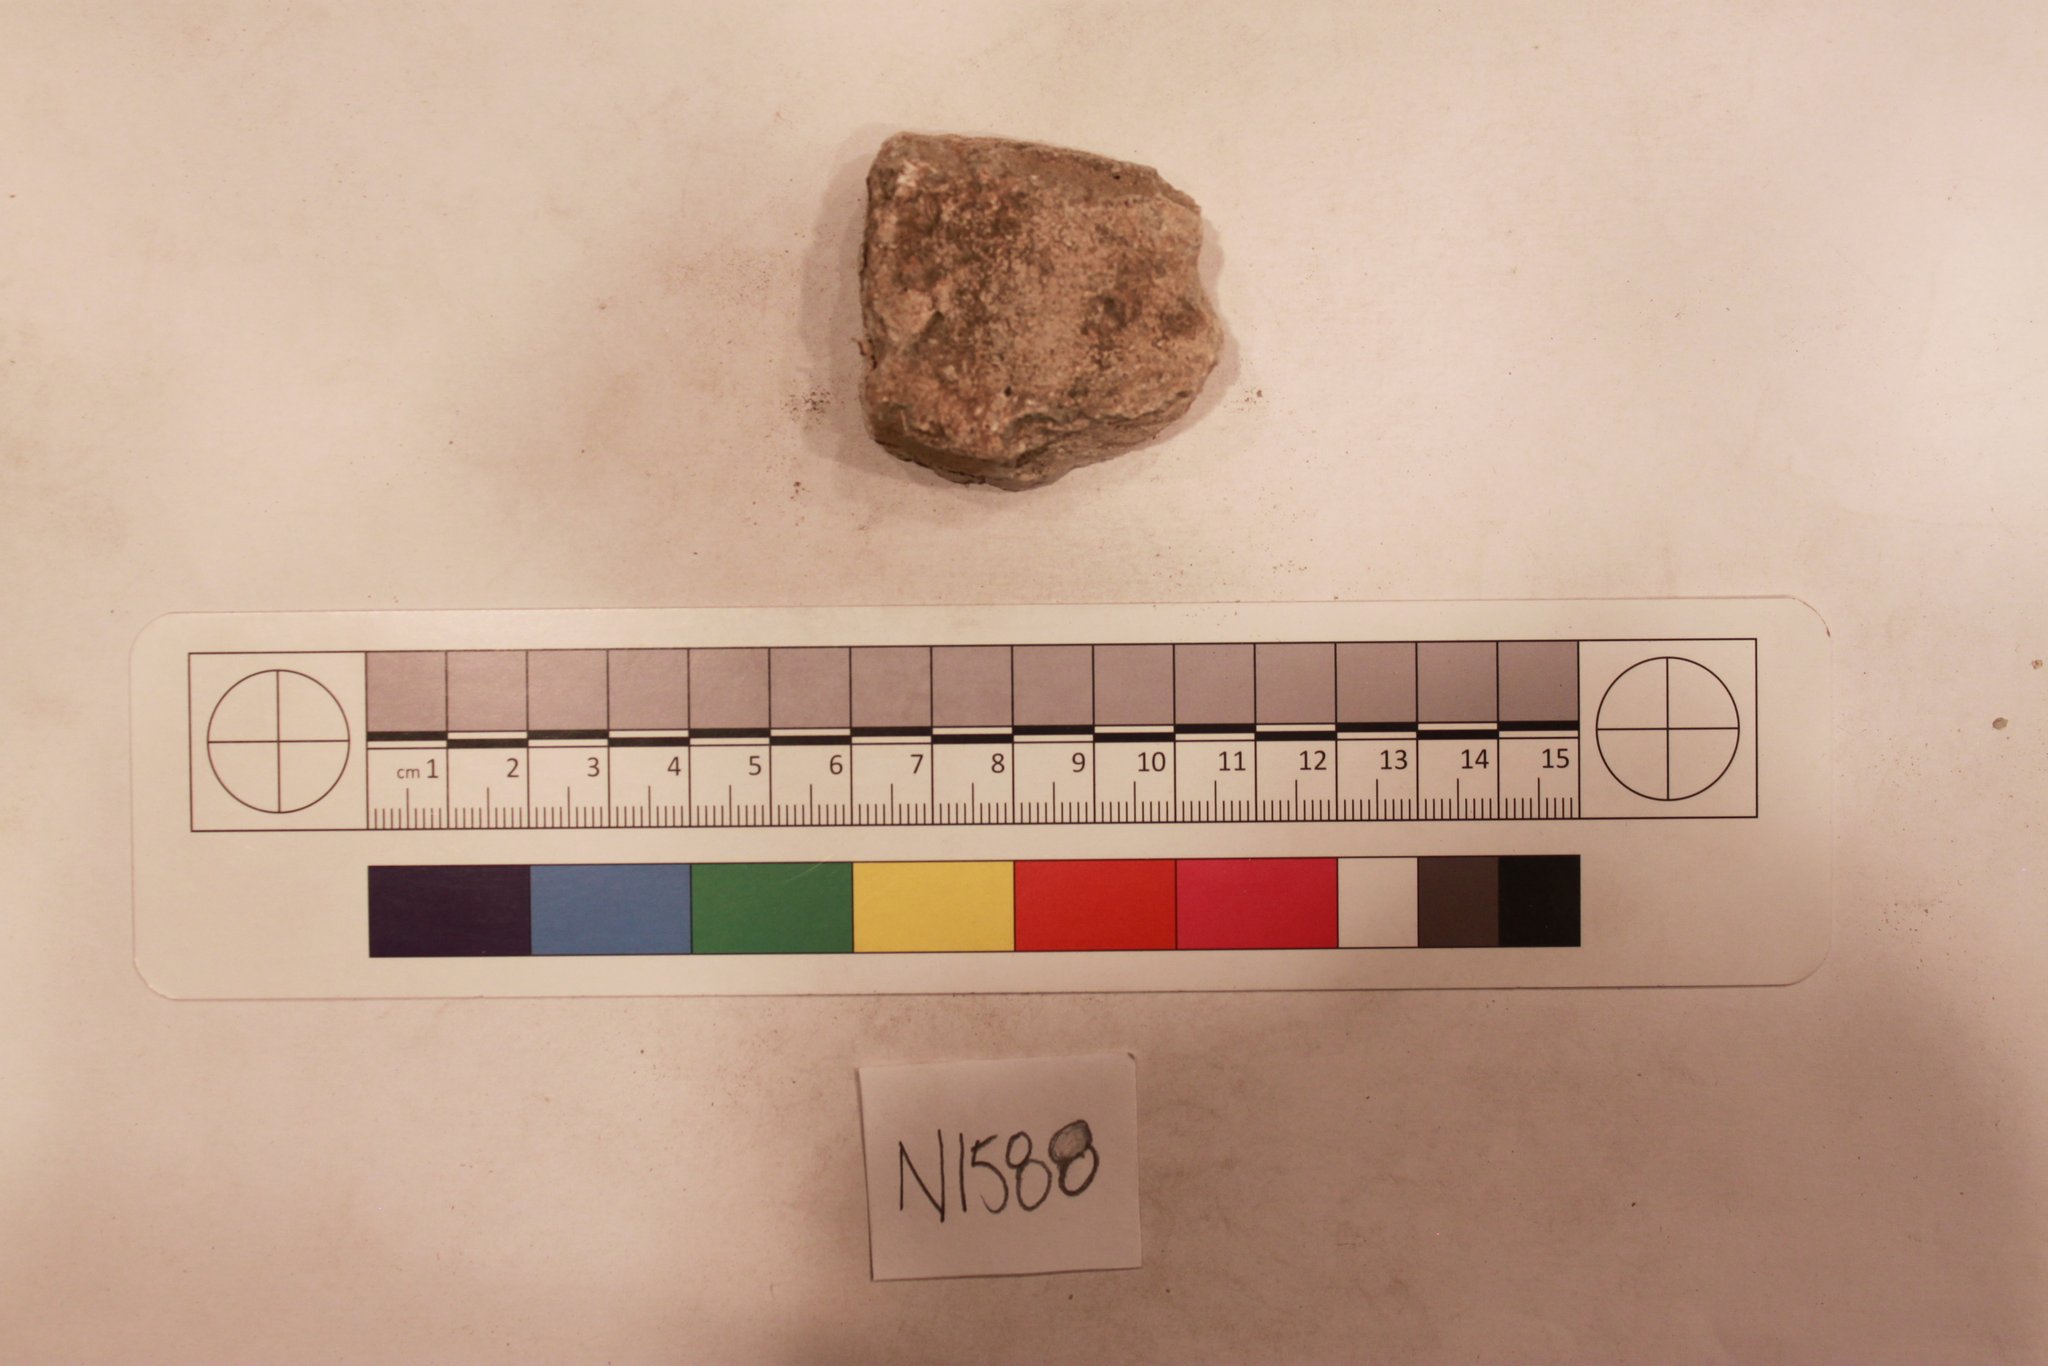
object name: fragment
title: Stucco Fragment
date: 701-1200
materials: plaster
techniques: carving, painting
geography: iran